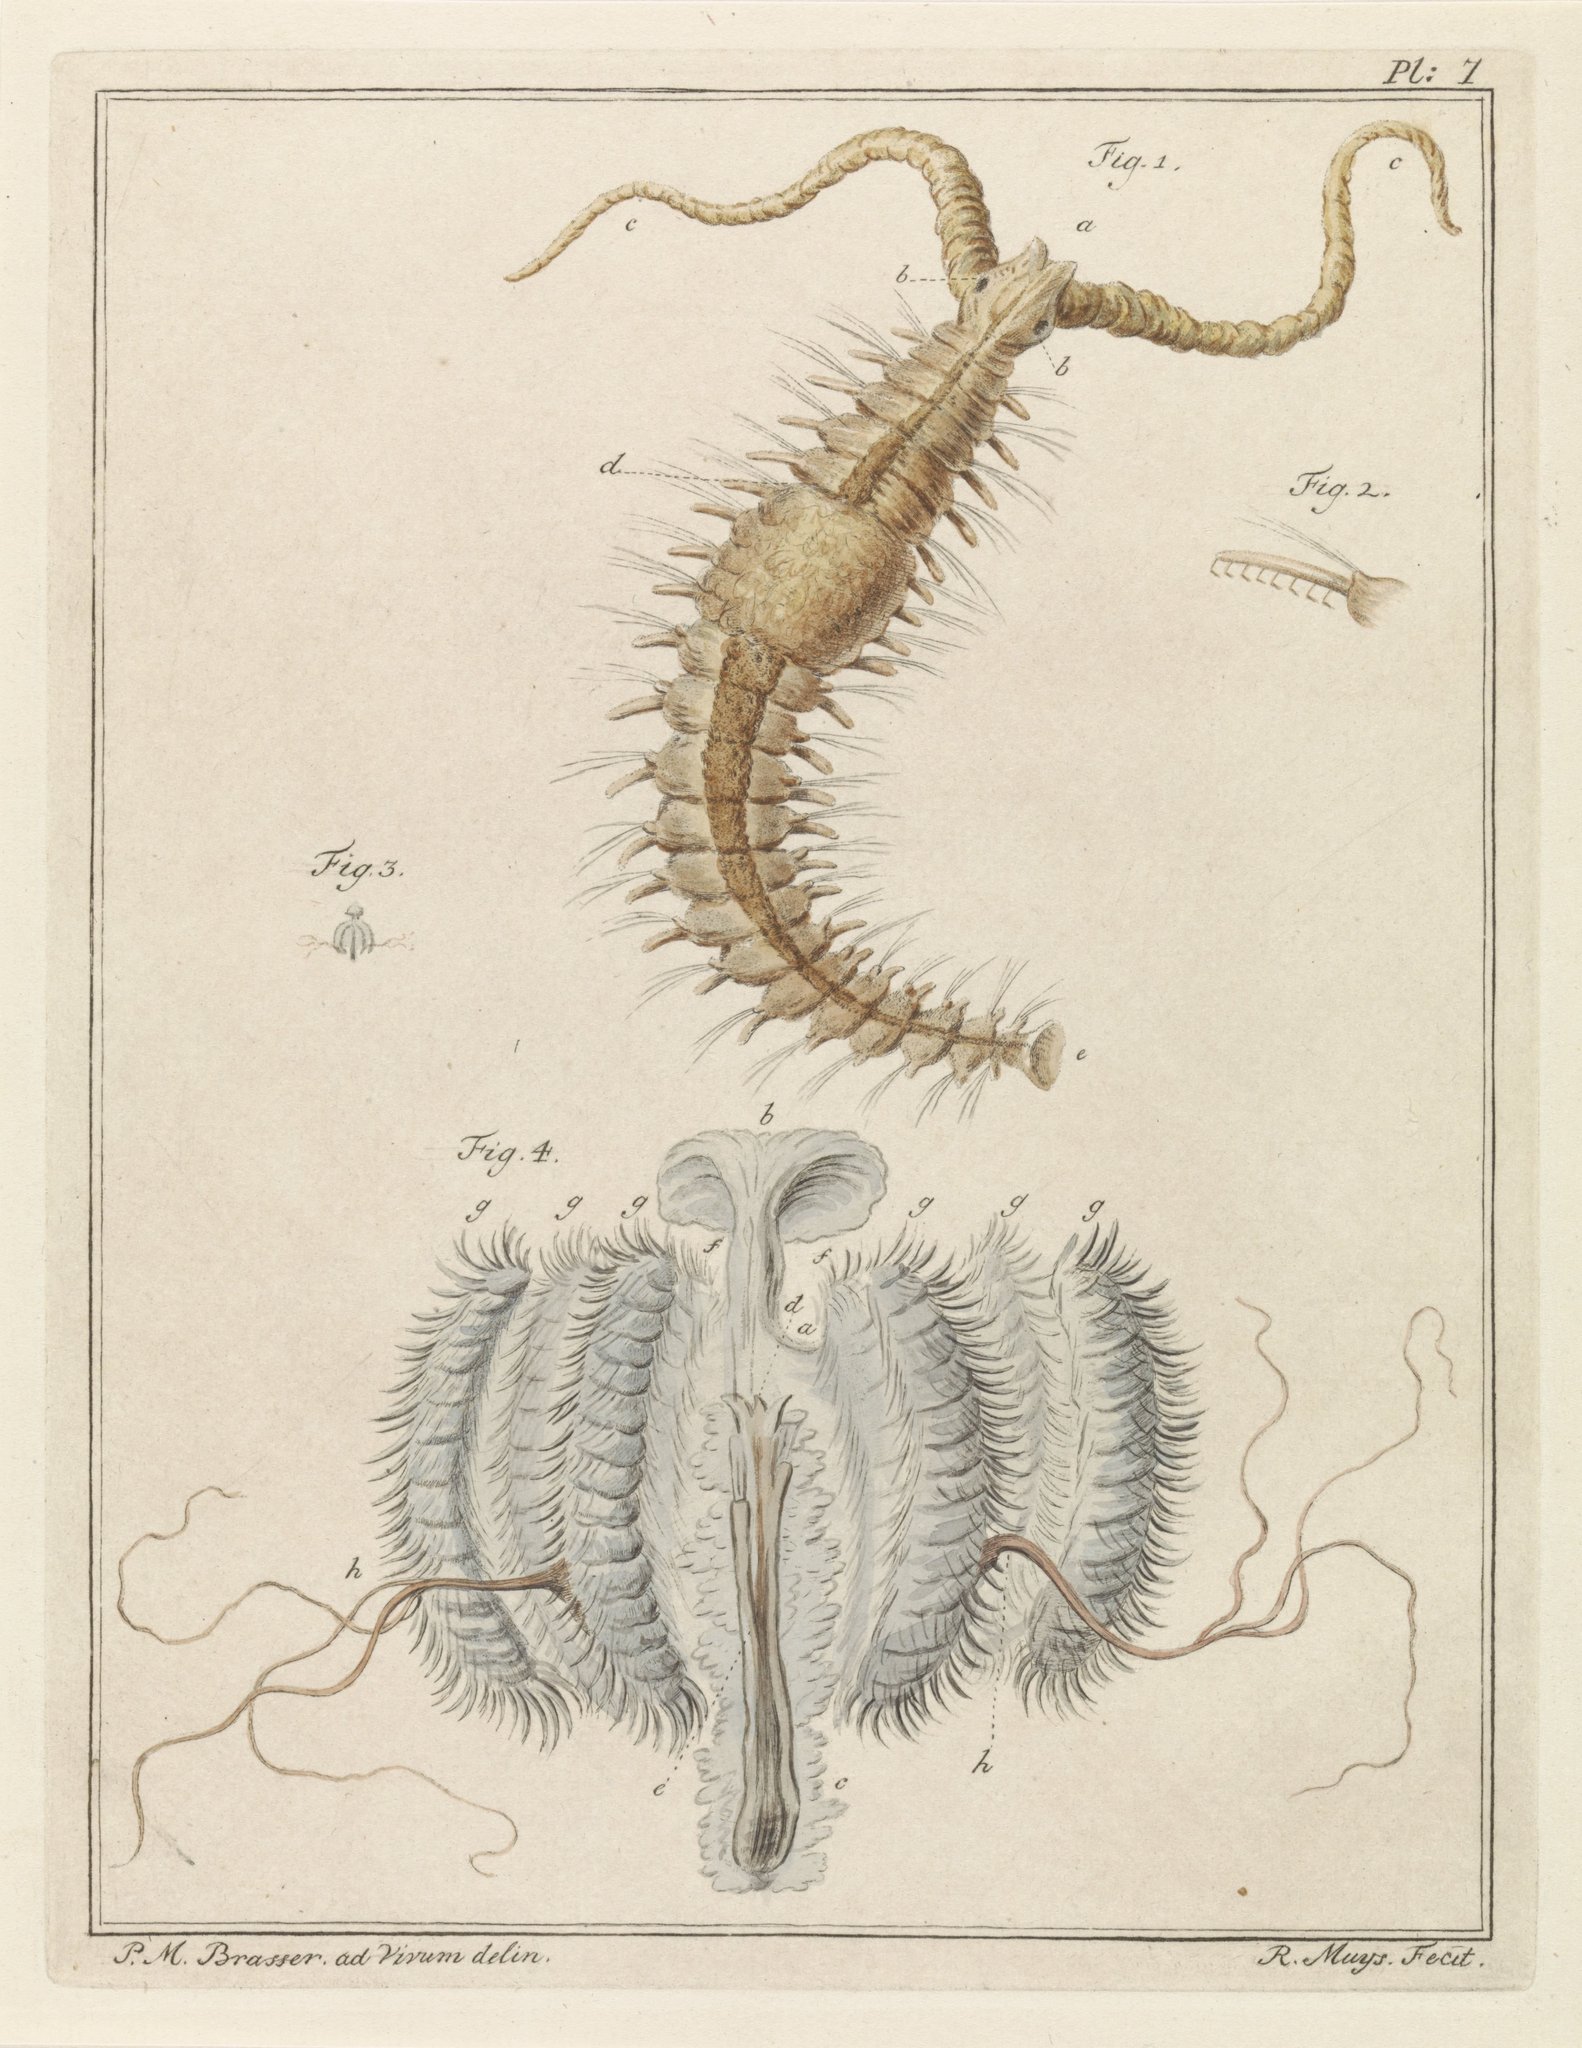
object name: print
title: Franjeworm en een ribkwalletje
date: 1778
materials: paper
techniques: etching, hand coloring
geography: rotterdam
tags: coelenterata (+ animals ~ biological investigation), coelenterata: jelly-fish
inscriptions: collector's mark: Lugt 2228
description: Figuur 1 en 2 tonen de Franjeworm, ook wel slikkokerworm genoemd, op ware grootte en uitvergroot. Figuur 3 en 4 tonen een ribkwalletje, ook wel de zeshoekige Beroë genoemd, op ware grootte en uitvergroot. Beiden zijn zeedieren. Rechtsboven: Pl. 7. Prent uit een boek over binnen- en buitenlandse land- en waterdieren.